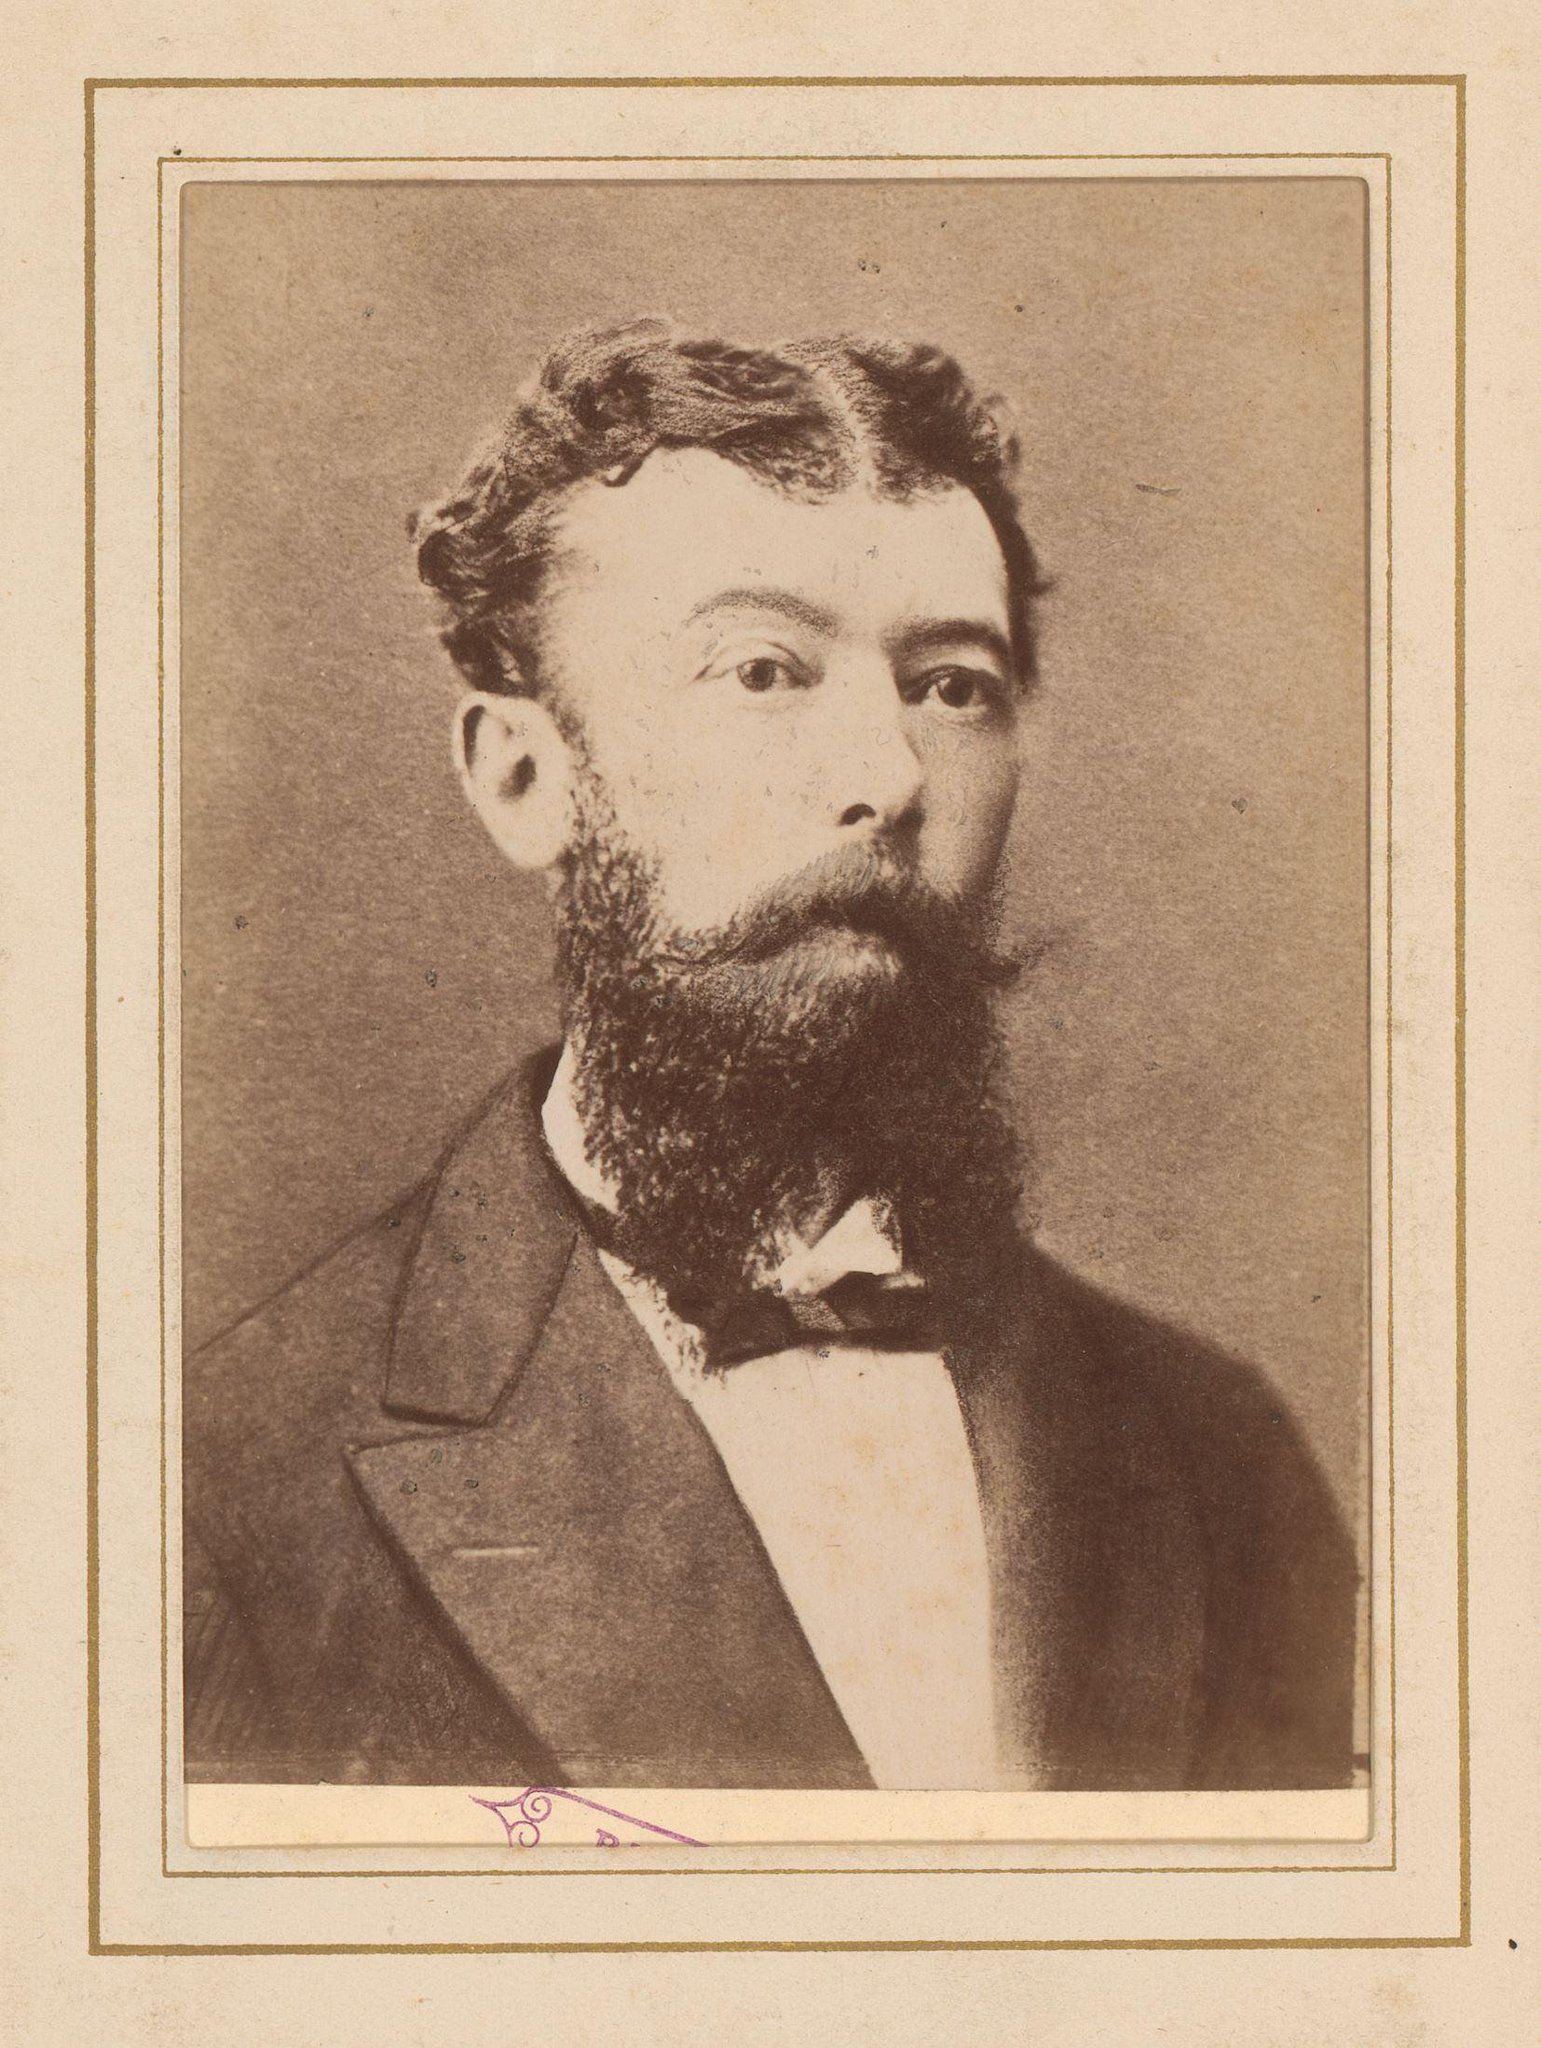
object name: cabinet photograph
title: Fotoreproductie van een getekend portret van een man met baard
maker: armand dandoy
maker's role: painter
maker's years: 1834-1898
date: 1878-1898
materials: cardboard, photographic support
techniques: albumen print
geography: namur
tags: historical persons, beard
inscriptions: inscription: ‘Spécialité/ de Vues/ et de / Photographies artistiques/ (...) ARMAND DANDOY/ Namur, Rue de la station 6./ Portraits instantanés pour Bébés. - Les Clichés sont conservés.’, inscription: ‘REPRODUCTION’